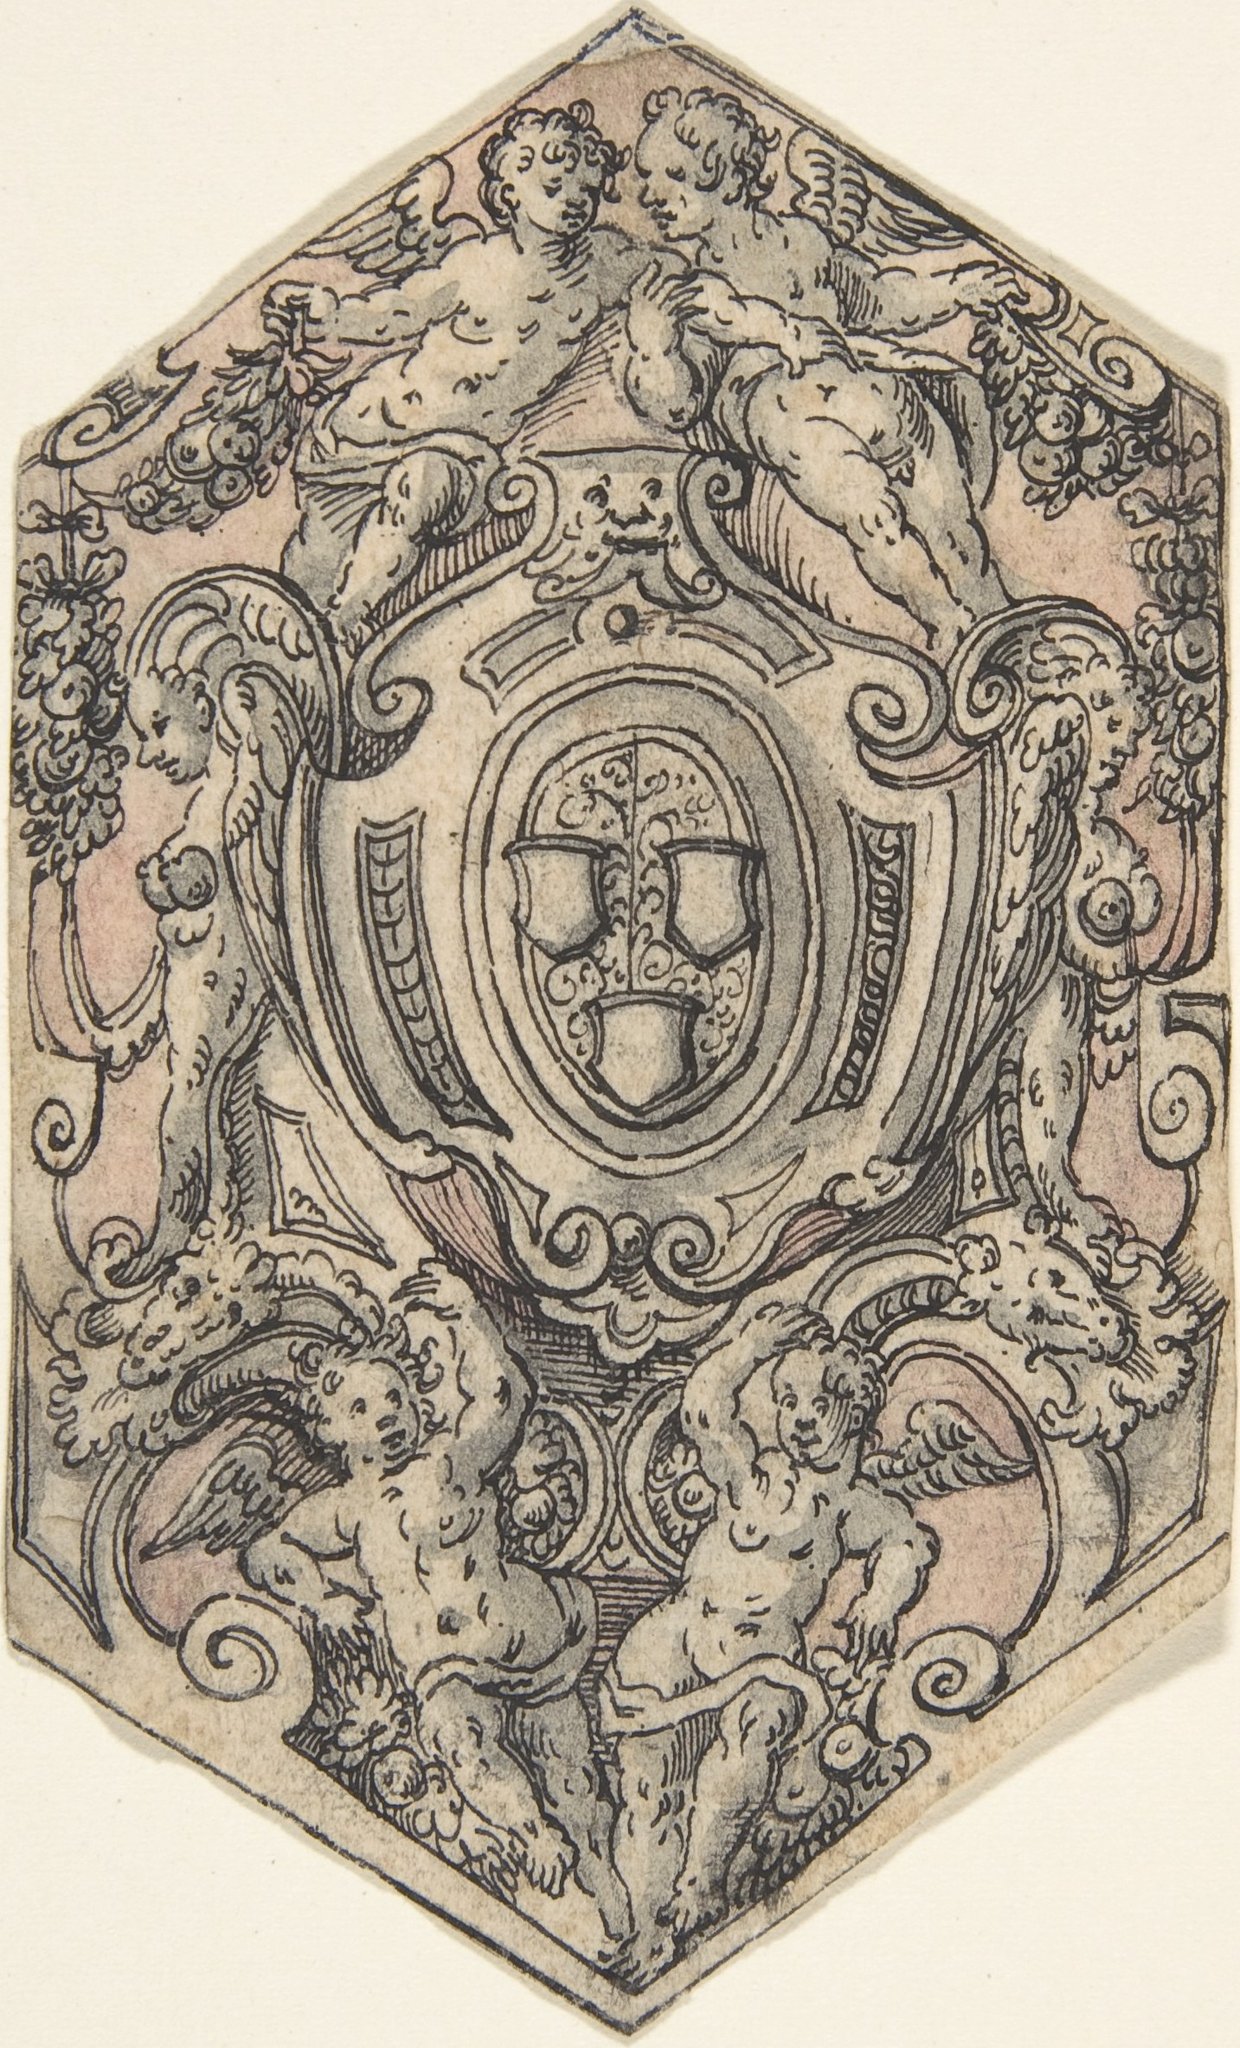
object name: drawing ornament architecture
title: Design for a Coat of Arms with Putti holding Garlands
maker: tobias stimmer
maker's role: artist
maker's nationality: swiss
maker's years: 1539-1584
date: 1550-1584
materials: ink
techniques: brush, pen, wash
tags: garlands,cupid,coat of arms